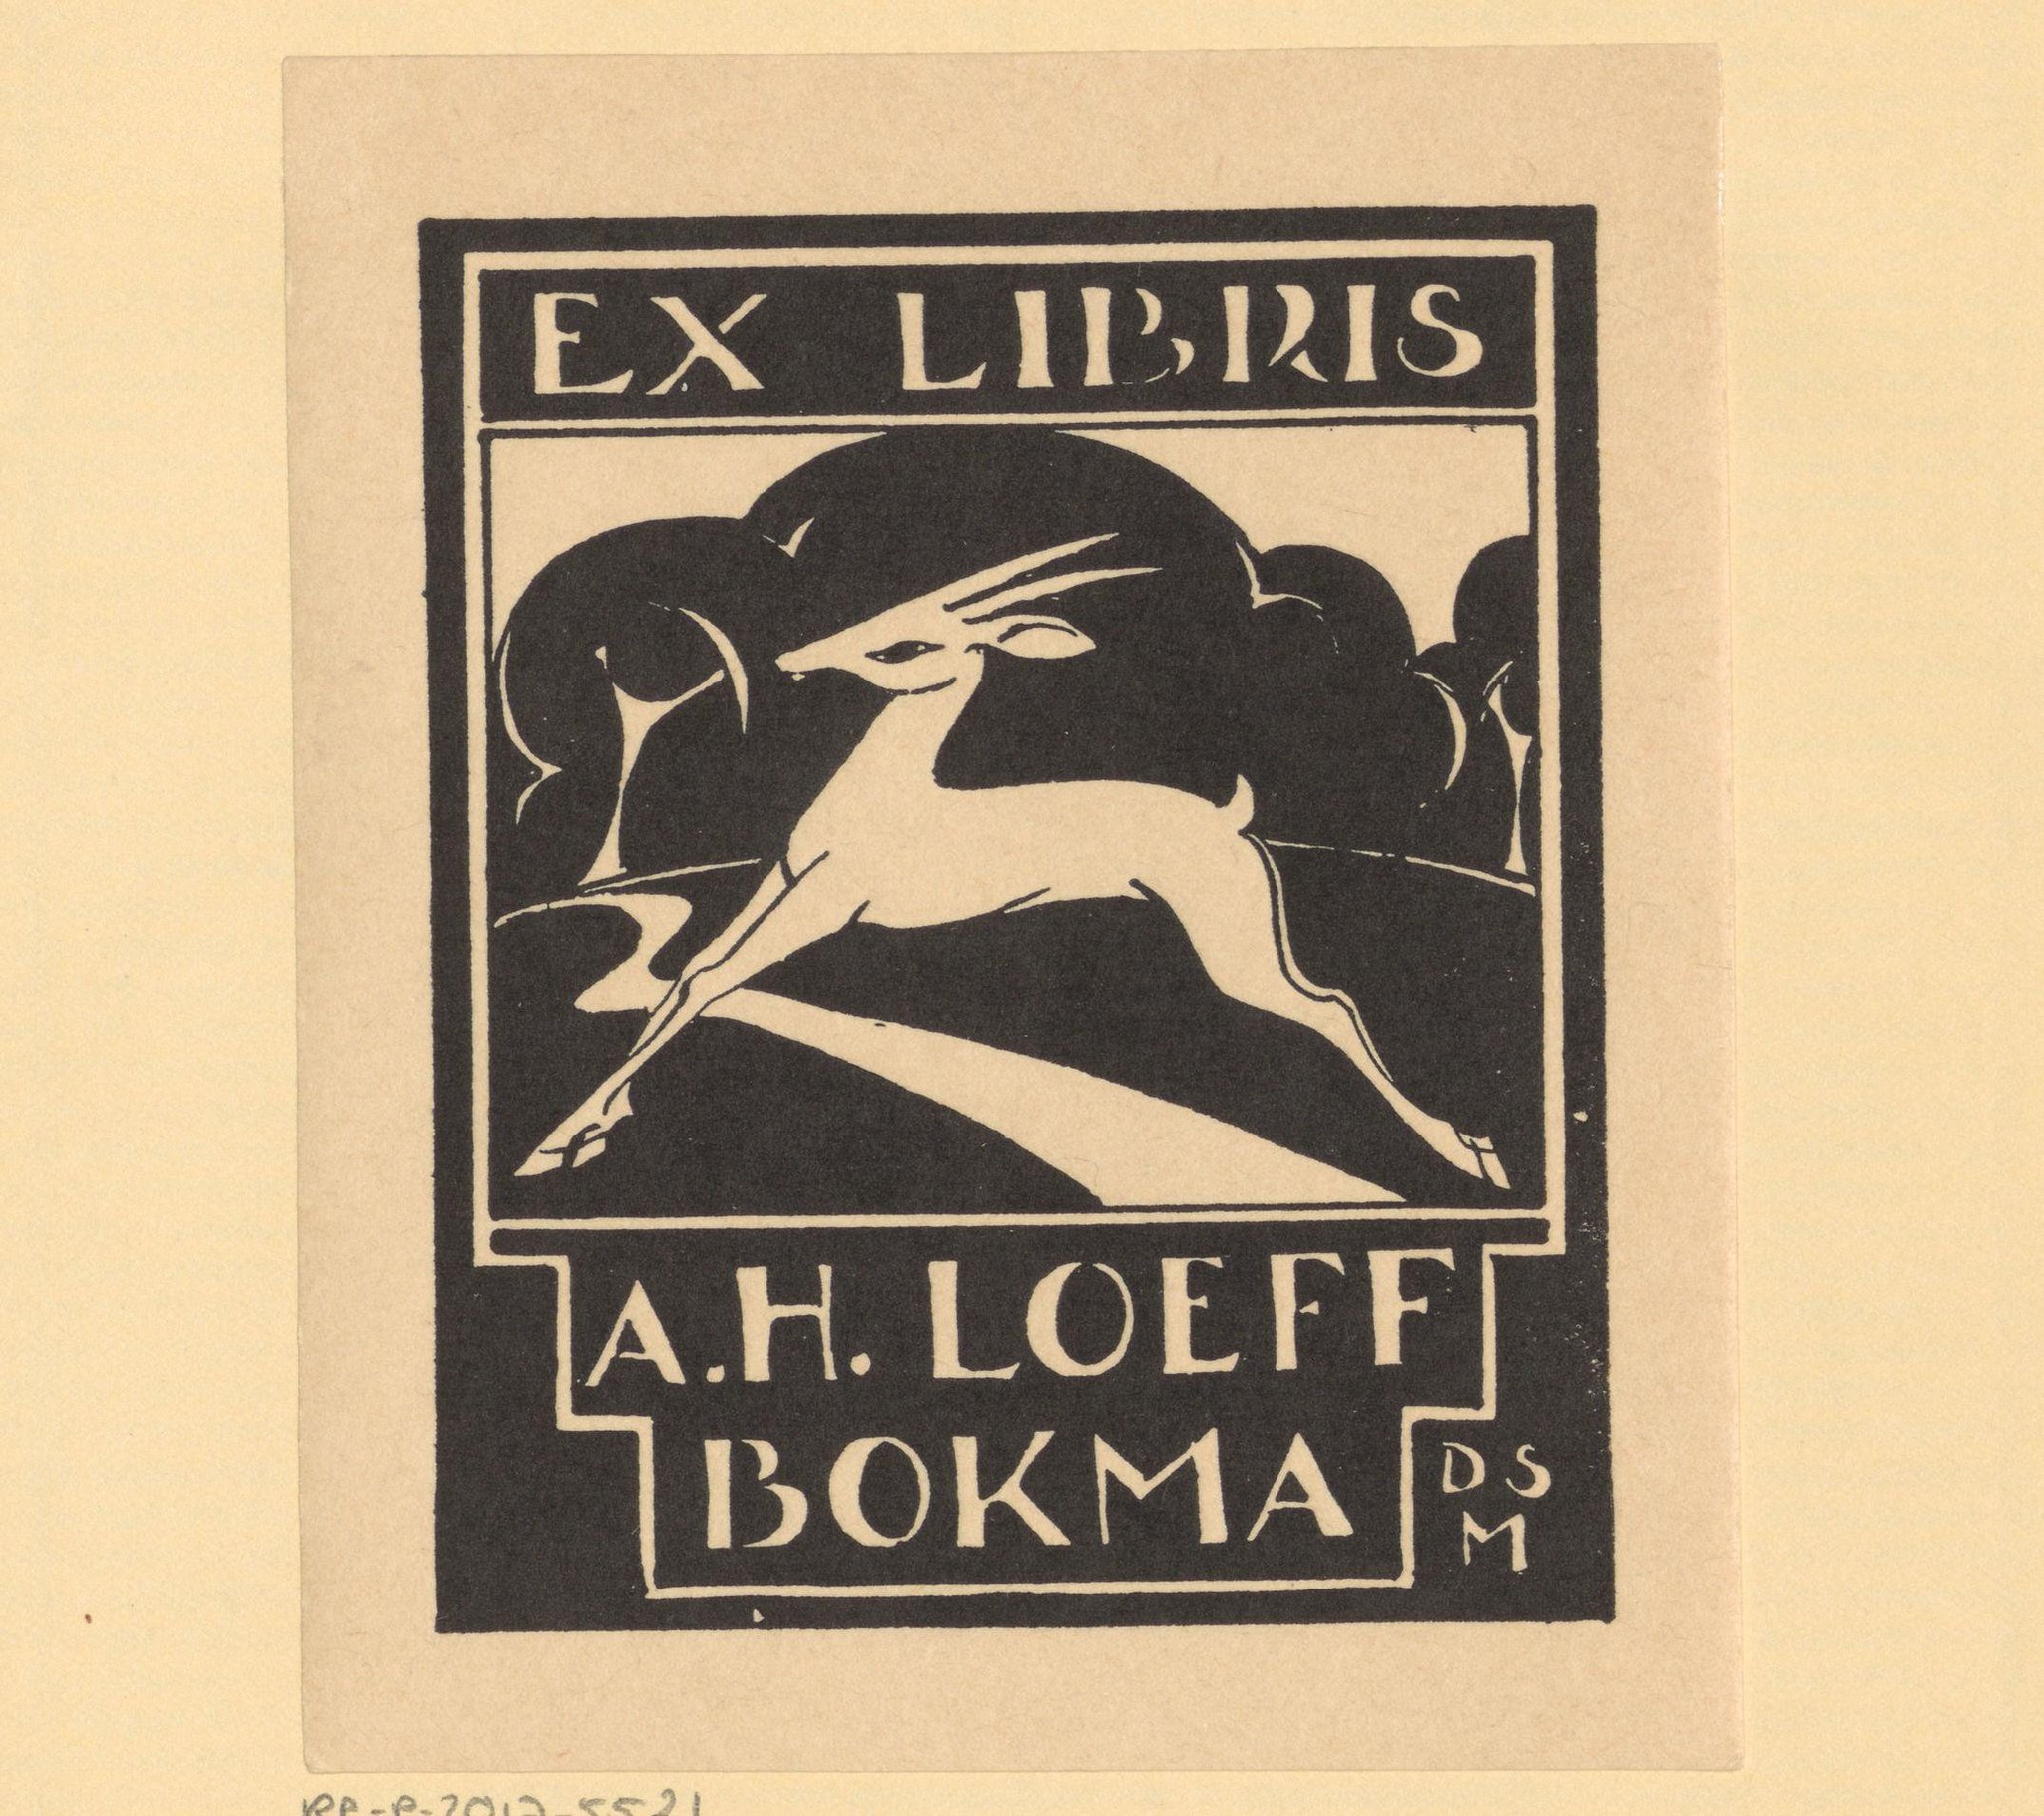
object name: bookplate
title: Ex libris van A.H. Loeff Bokma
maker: dora struick du moulin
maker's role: draughtsman, print maker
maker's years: 1866-1937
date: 1929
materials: paper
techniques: woodcut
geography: netherlands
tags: hoofed animals: deer